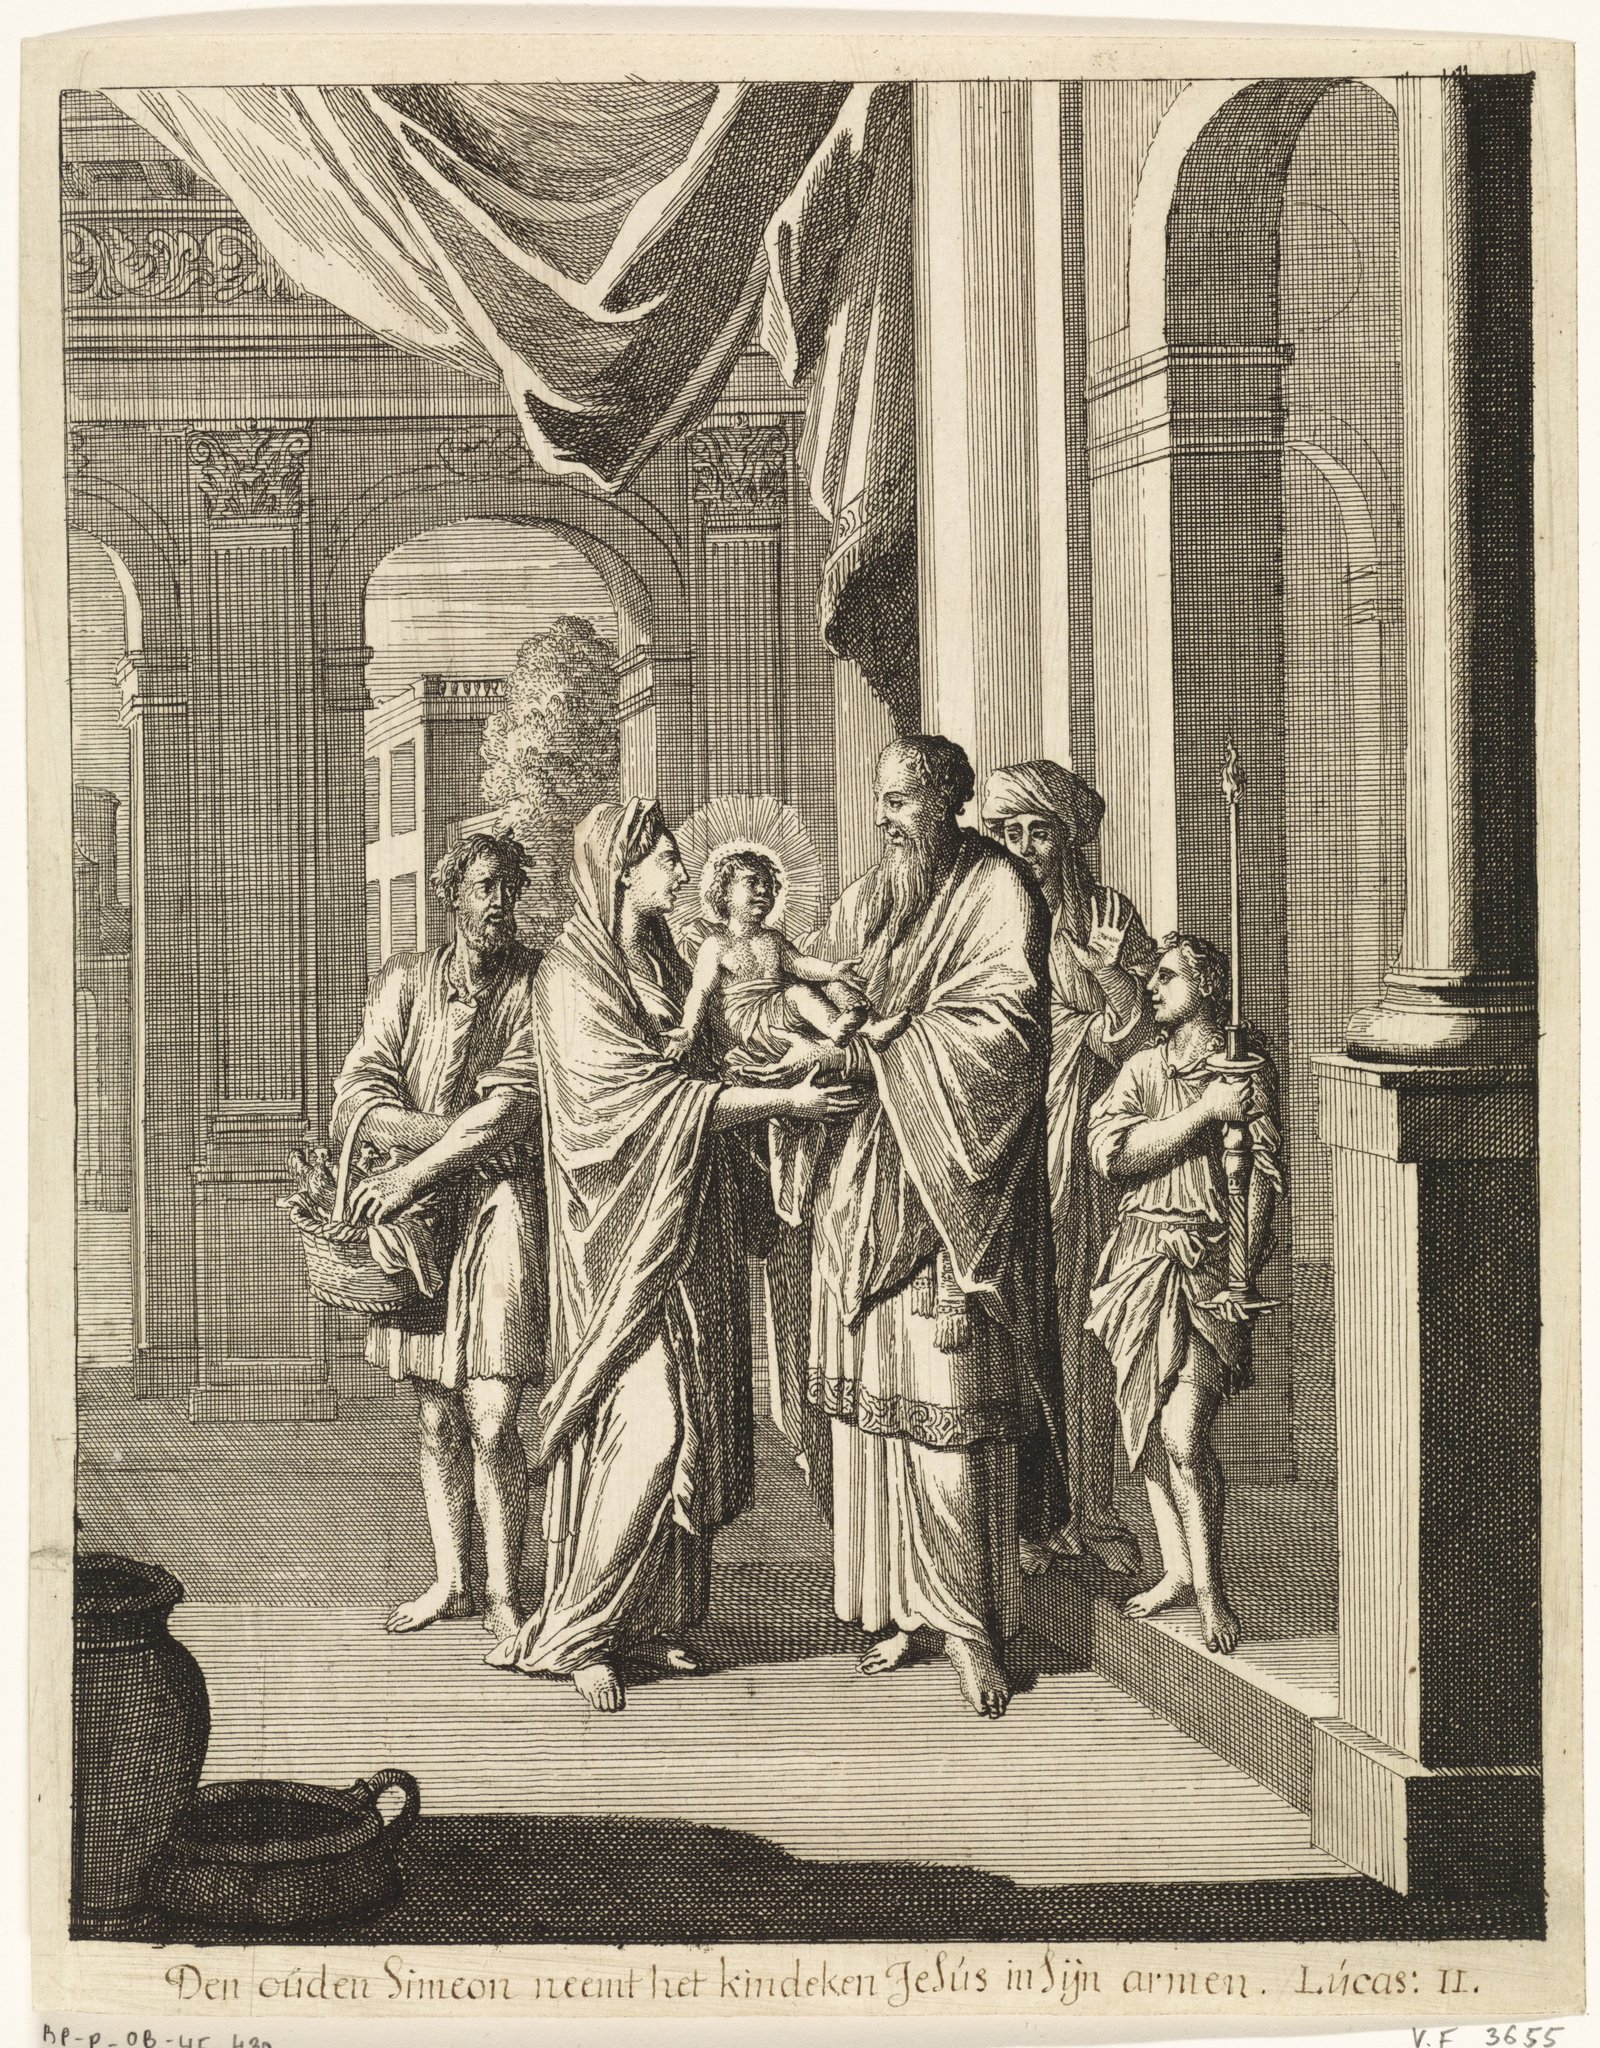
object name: print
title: Simeon en het Christuskind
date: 1708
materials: paper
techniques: etching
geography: nuremberg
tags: simeon, holding the christ-child, sings his canticle: 'nunc dimittis'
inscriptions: collector's mark: Lugt 2228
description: Proefdruk van een prent welke is opgenomen als illustratie in: Historiae Celebriores Veteris Testamenti. Christoph Weigel, 1708.